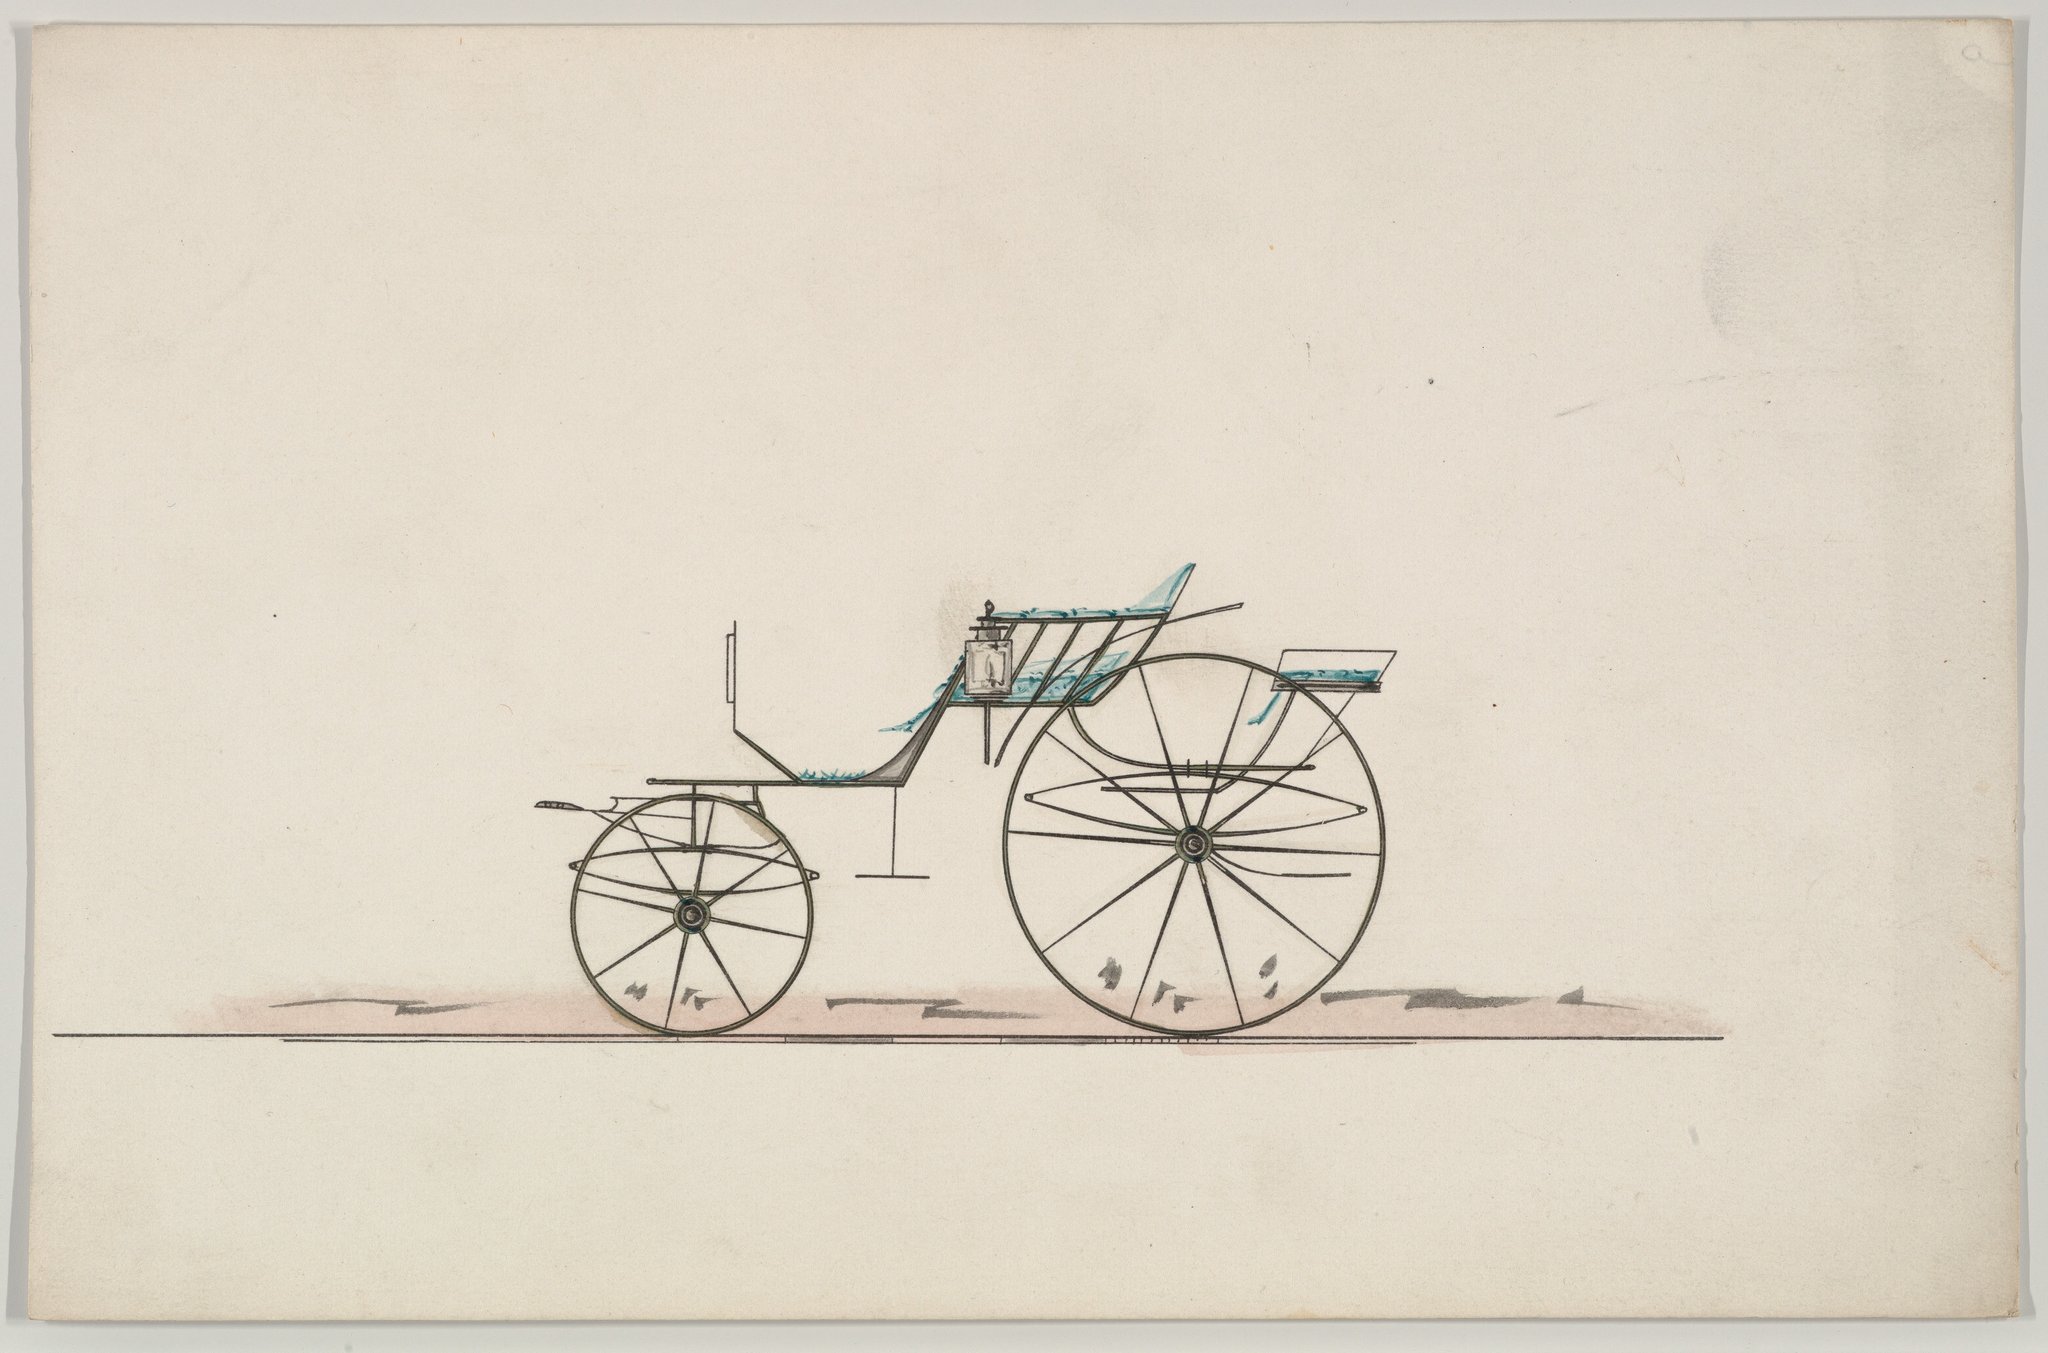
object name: drawing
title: Spindle Seat Phaeton (unnumbered)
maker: brewster & co.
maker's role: manufacturer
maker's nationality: american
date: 1870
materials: gouache, gum arabic, ink, watercolor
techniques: pen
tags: carriages